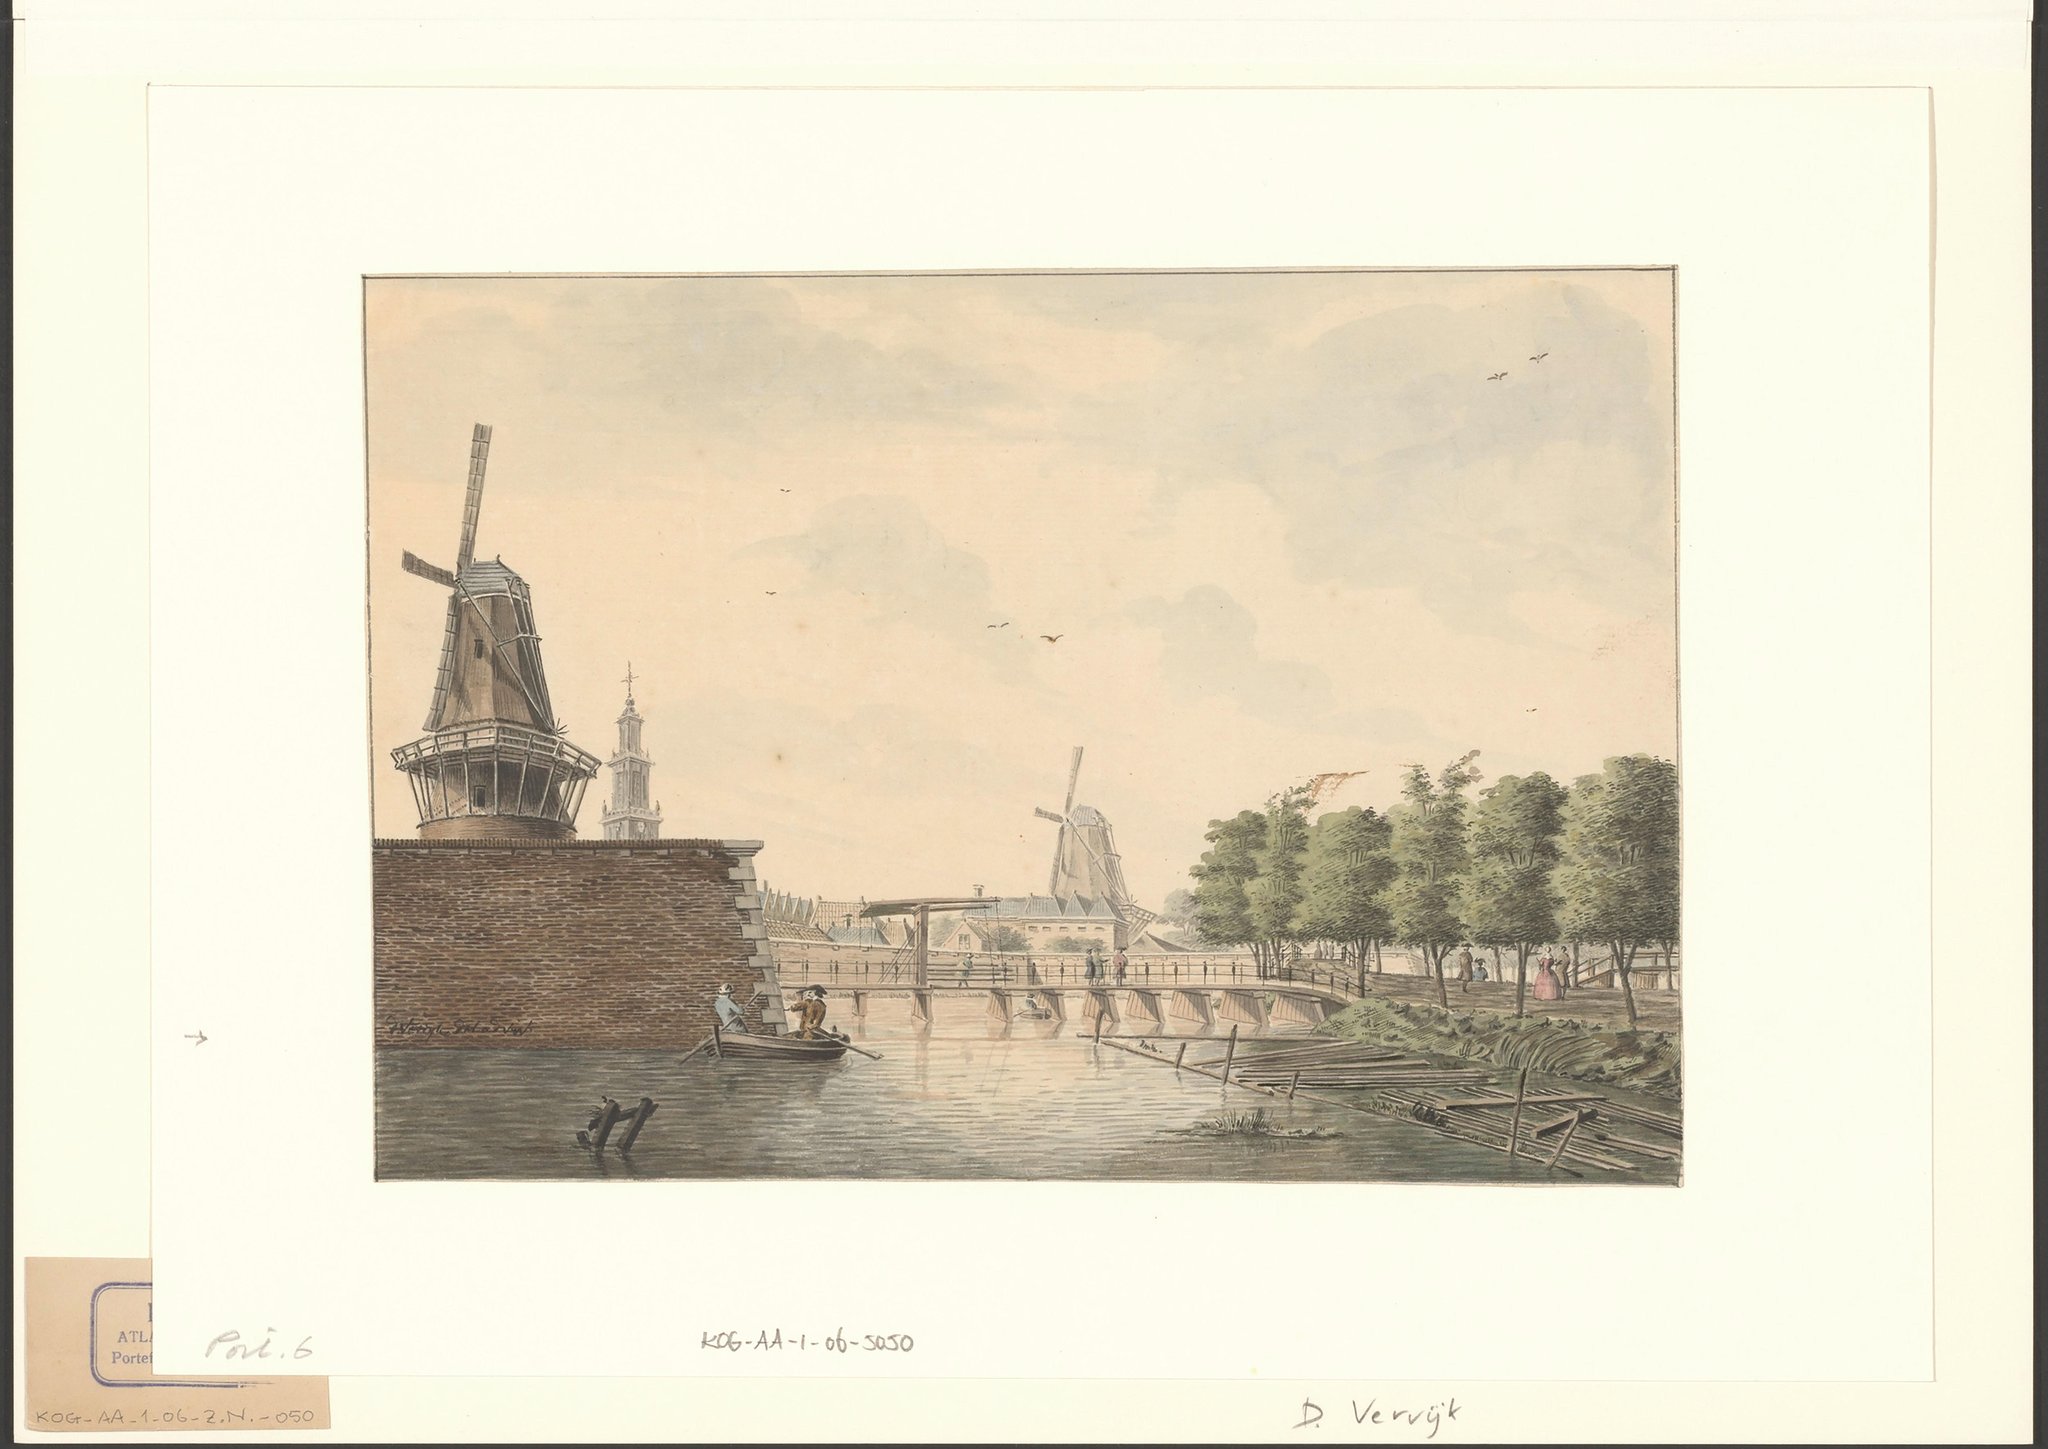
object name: drawing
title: Gezicht van het Singel op de Westertoren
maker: dirk verrijk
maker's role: draughtsman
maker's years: 1734-1786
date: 1744-1786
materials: ink, paper, pencil, watercolor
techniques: brush, pen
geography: amsterdam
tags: tower, clock tower ~ monumental adornment, city-view in general; 'veduta', river, windmill in landscape, bridge in city across river, canal, etc.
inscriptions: collector's mark: ‘6’ Lugt 1641b, signature: ‘d.Verrijk del ad viv.’, inscription: ‘Gesigt buyte de Zaagmolen poort / te Amsterdam’, inscription: ‘Port. 6’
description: Onderwerpsrubriek binnen de Atlas Amsterdam: Buitensingel of wel: Gezichten langs en op de Stadsvest van Haarlemmerpoort tot Raampoort.